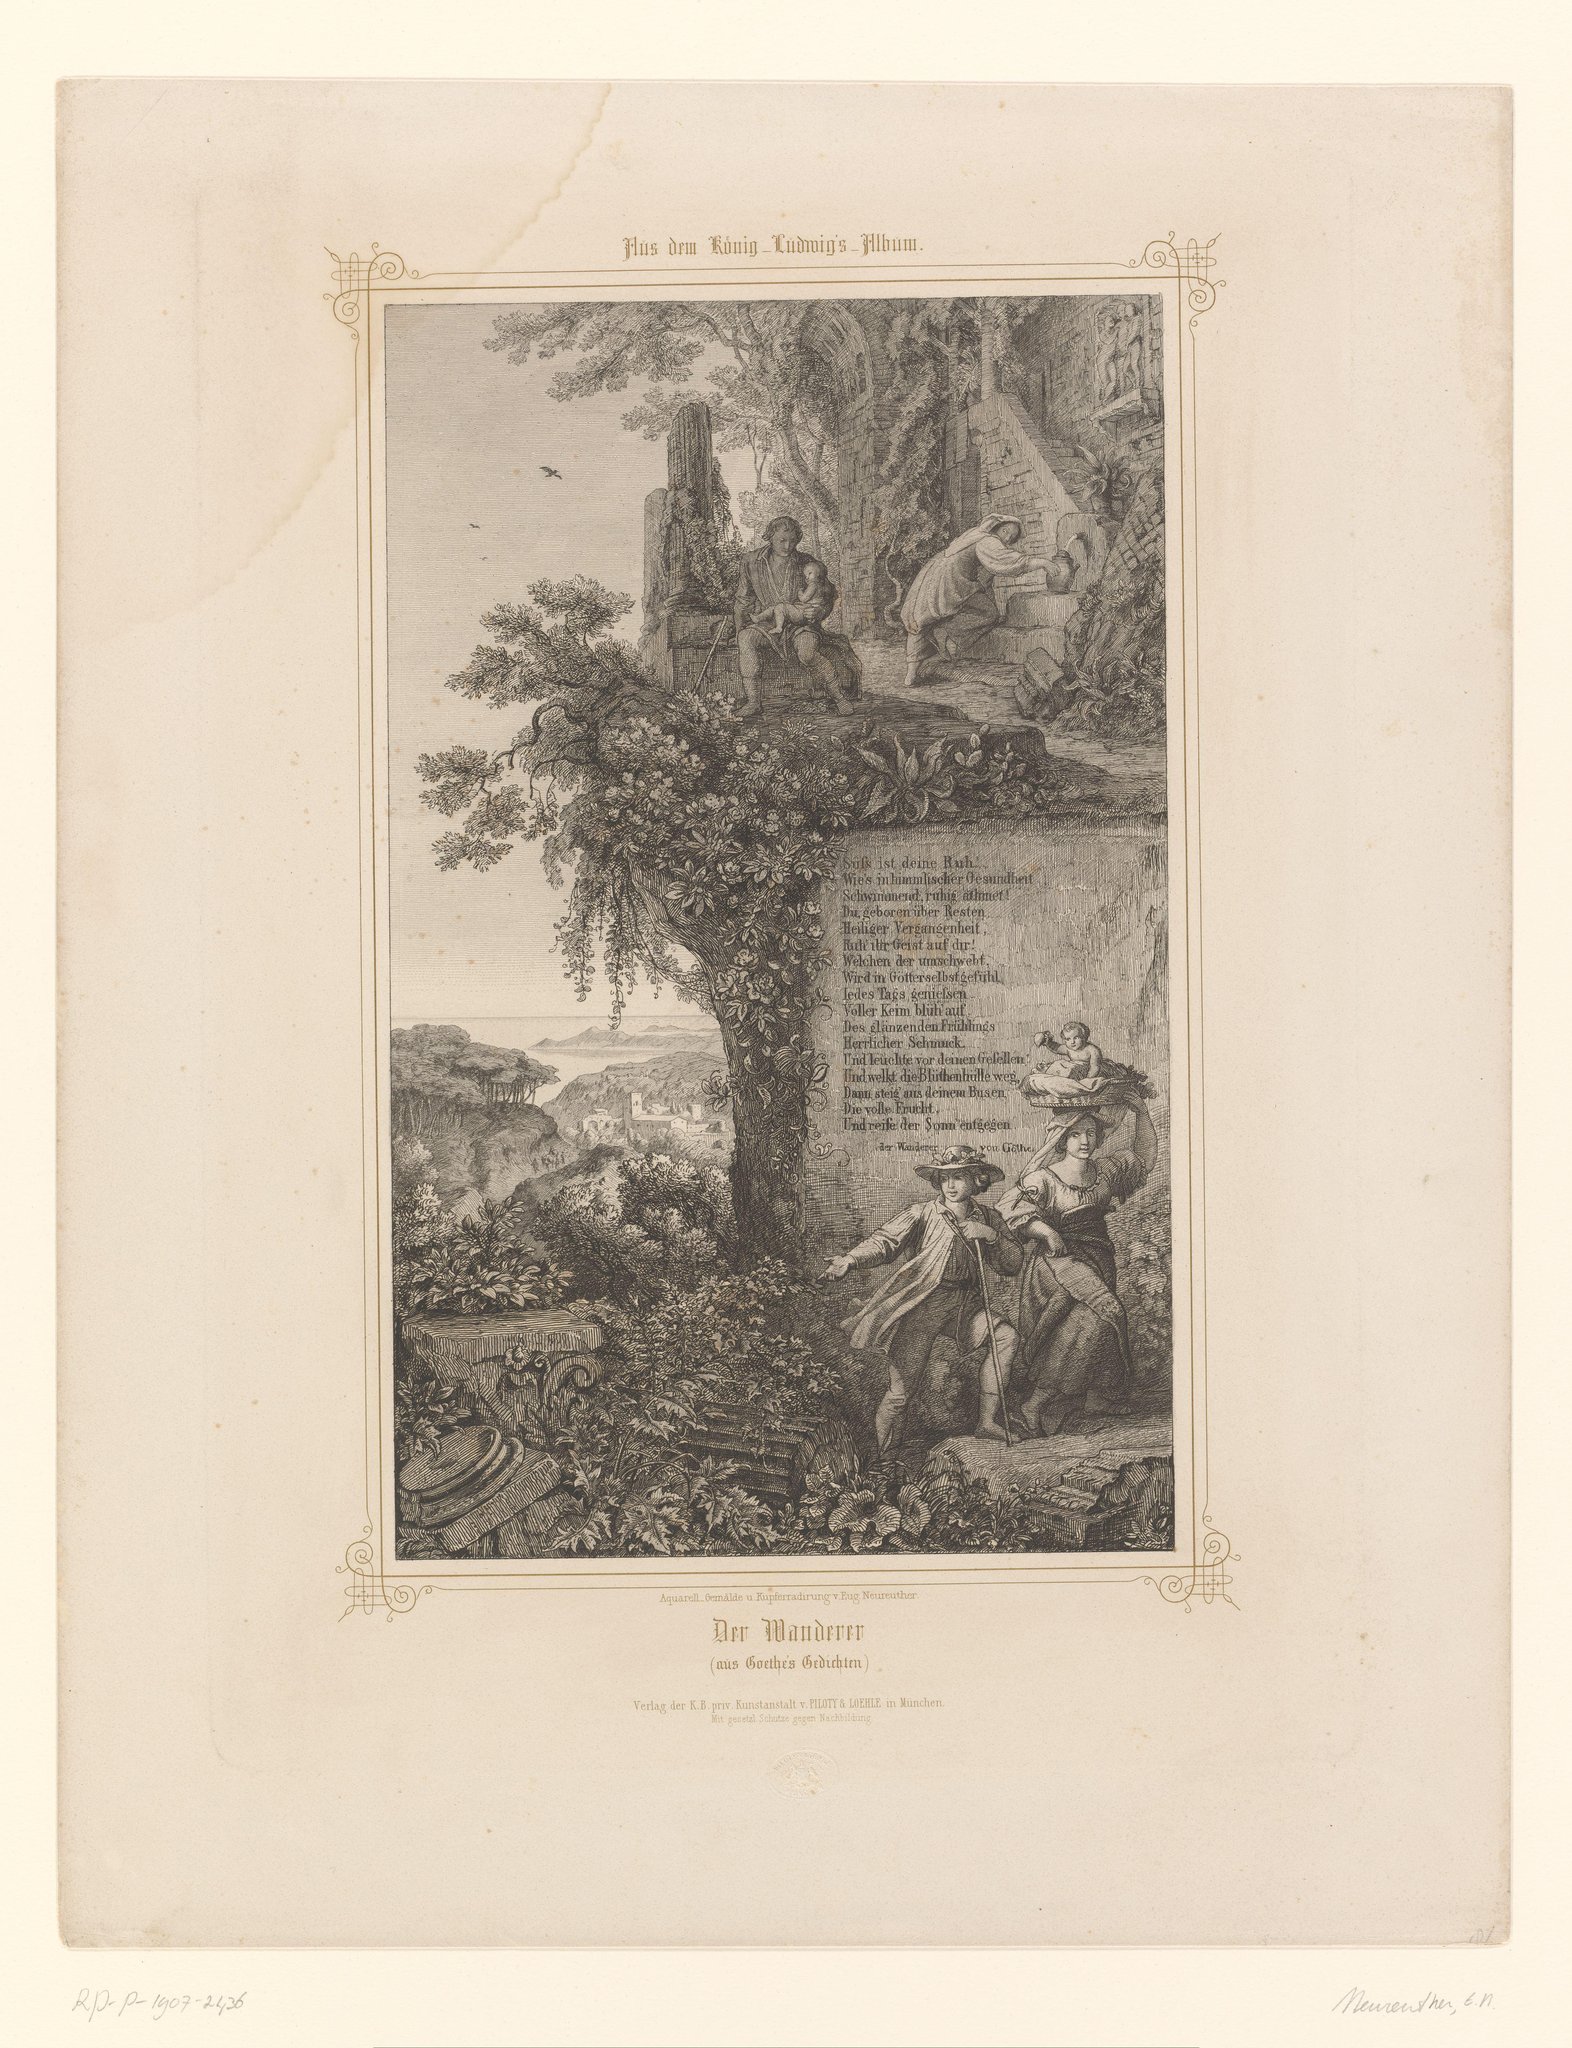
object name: print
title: Berglandschap met reizigers en een gedicht van Goethe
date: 1851-1859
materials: paper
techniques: etching, lithograph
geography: munich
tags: lodewijk i (koning van beieren), 'en route', traveller under way, landscapes (+ landscape with figures, staffage), king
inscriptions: check stamp: ‘Piloty & Loehle München’, collector's mark: Lugt 2228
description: Deze prent maakt deel uit van de verzameling 'Album Seiner Majestät des Königs Ludwig I. von Bayern' of 'König-Ludwigs Album'; een serie prenten die op 9 oktober 1850 aan Lodewijk I van Beieren werd aangeboden en tussen 1851 en 1859 door Piloty & Löhle werd uitgegeven in München.